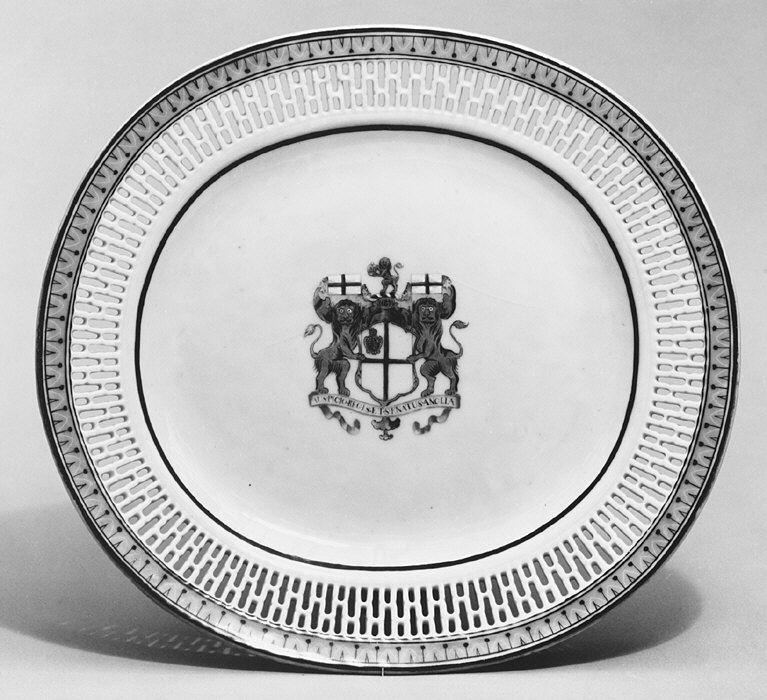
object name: dish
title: Dish (one of a pair)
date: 1800-1810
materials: hard paste porcelain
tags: lions,coat of arms